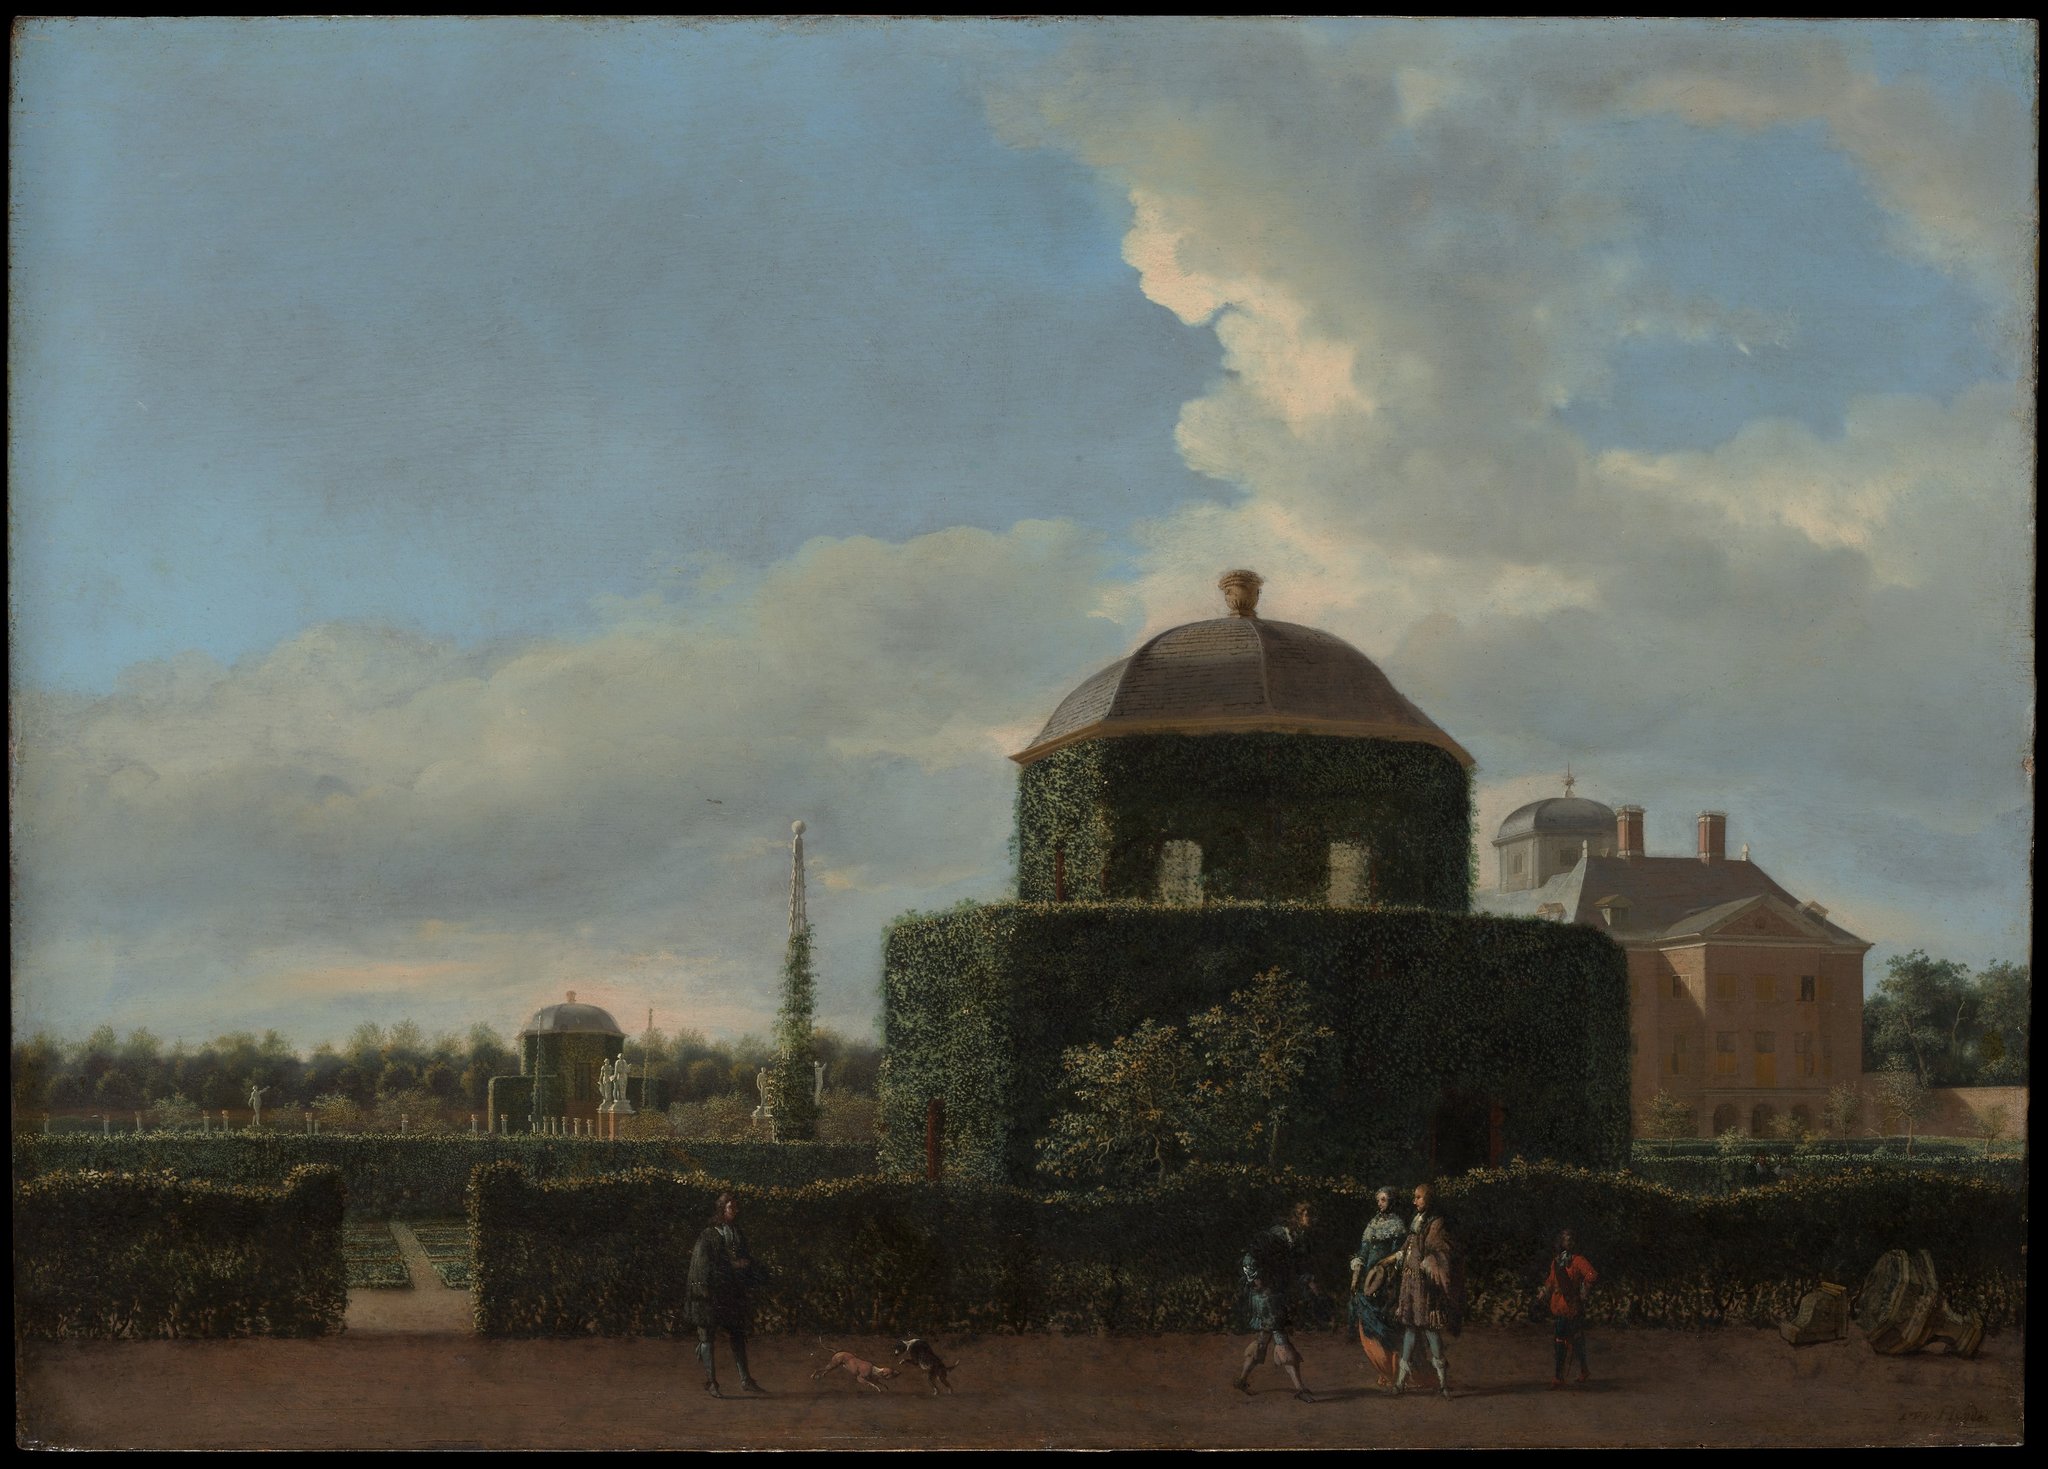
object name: painting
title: The Huis ten Bosch at The Hague and Its Formal Garden (View from the East)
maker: jan van der heyden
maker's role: artist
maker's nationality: dutch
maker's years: 1637-1712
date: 1668-1670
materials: oil, wood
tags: houses,gardens